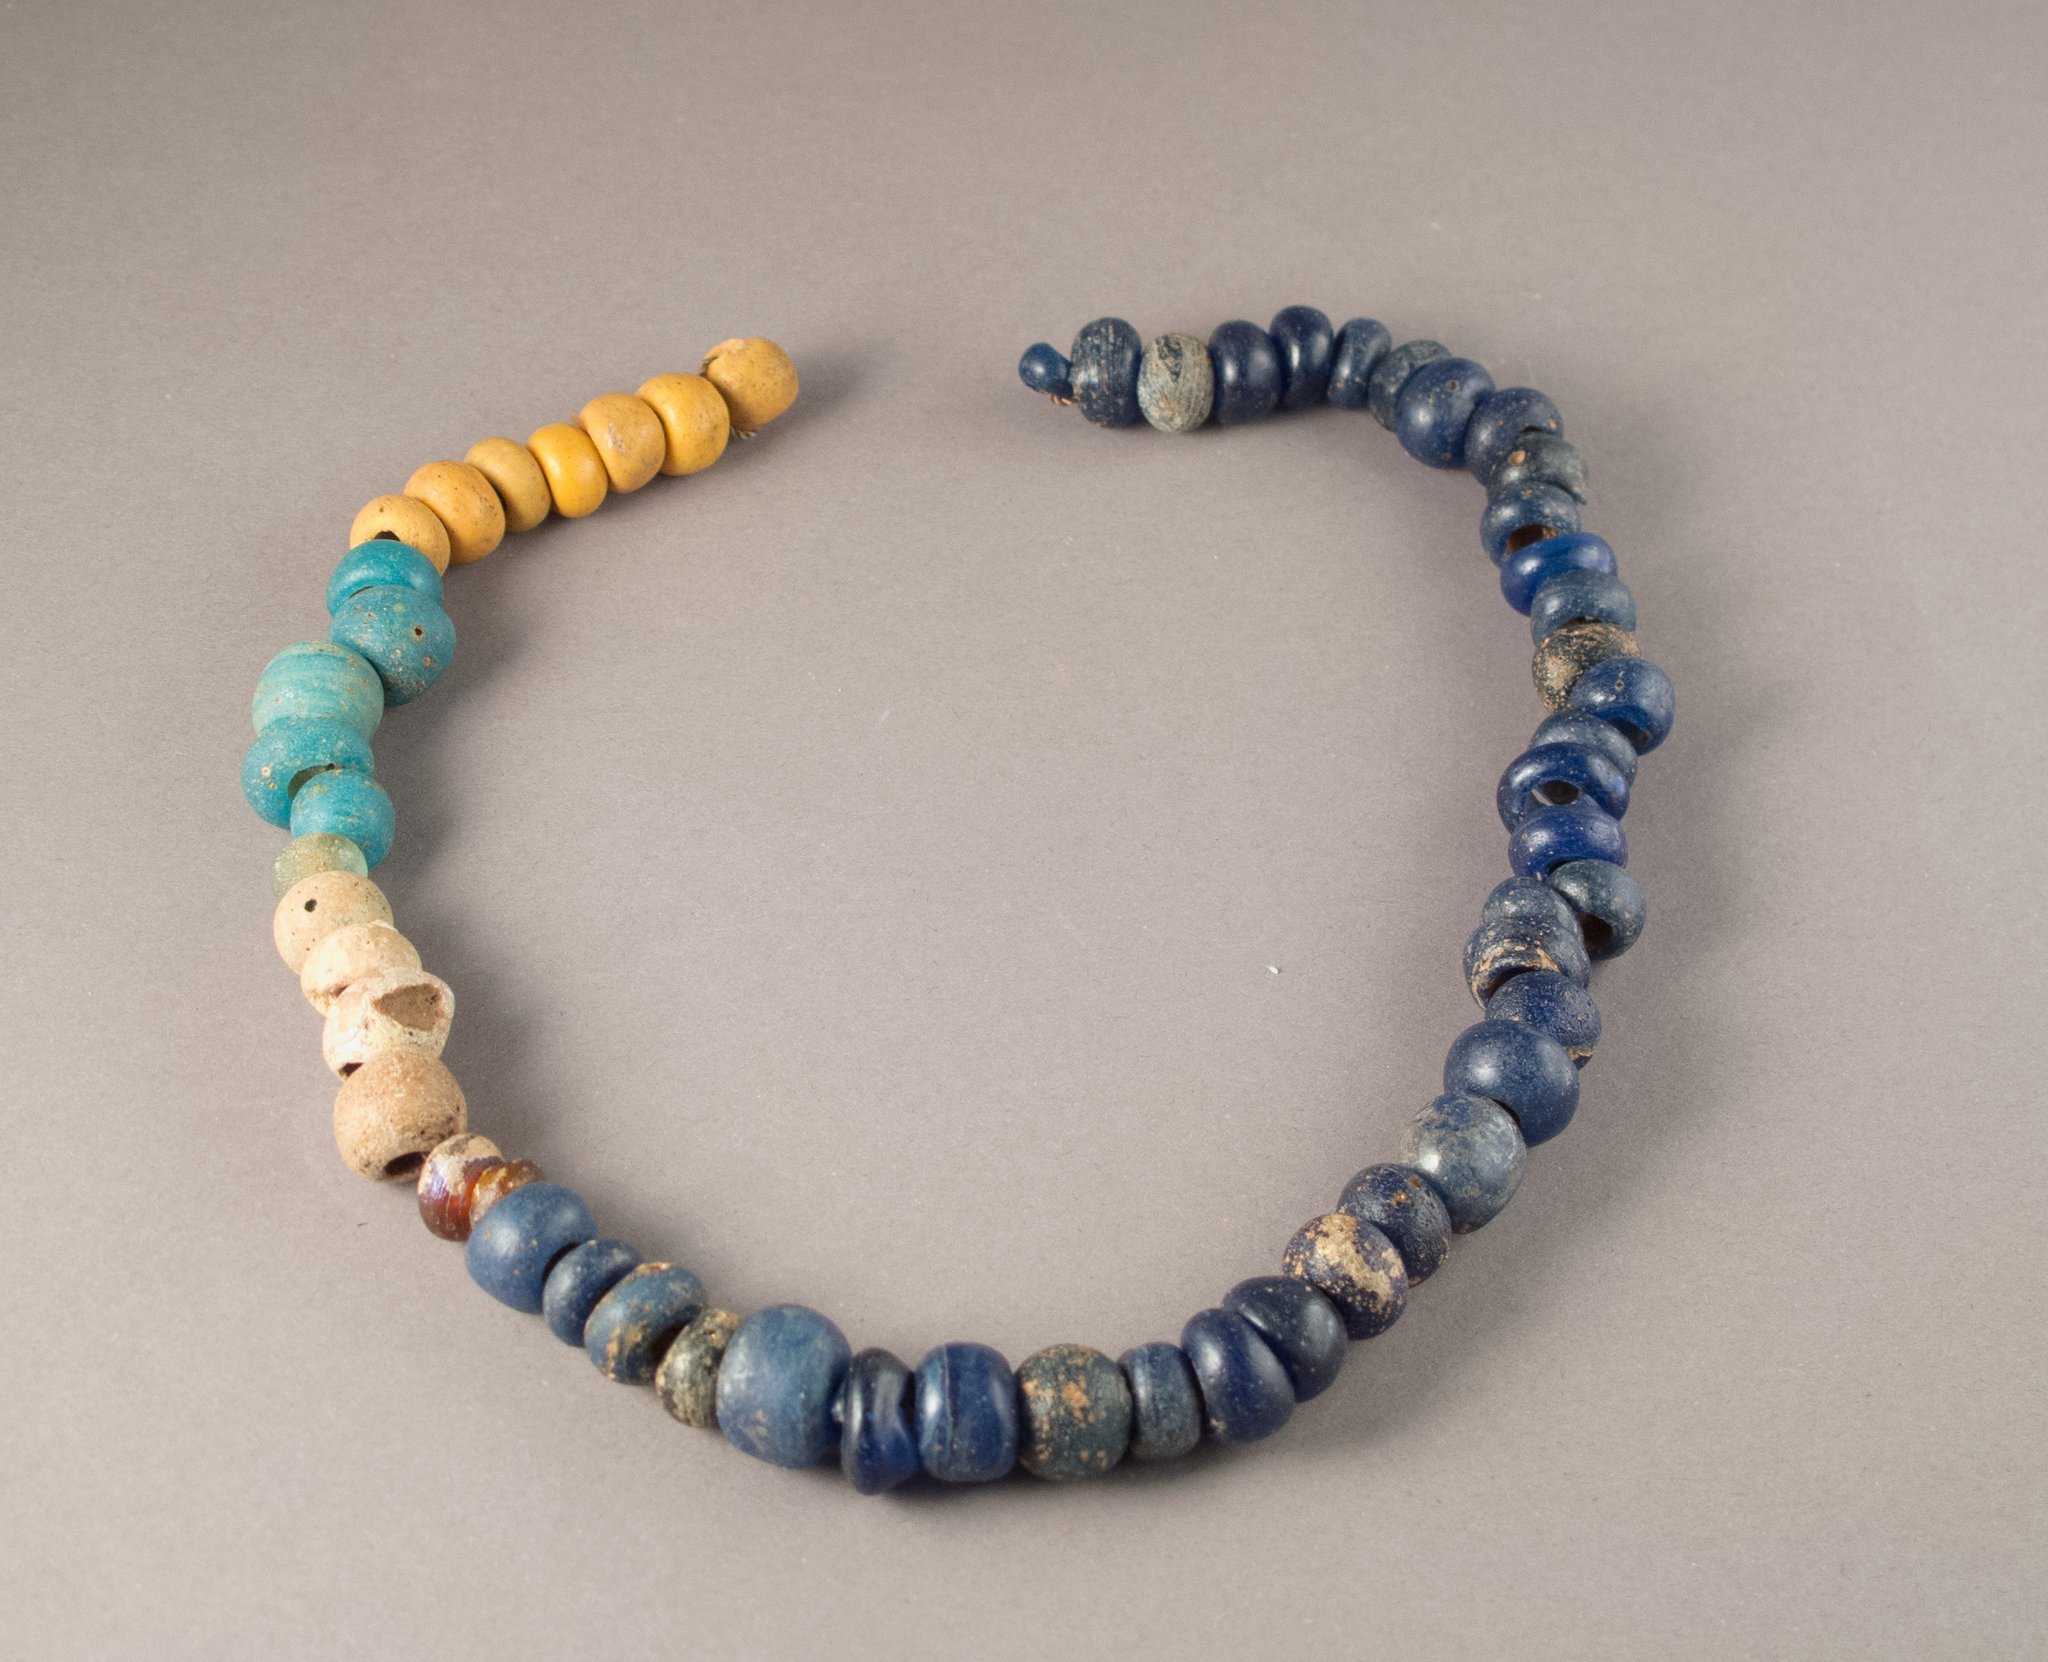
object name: bead, 56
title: Glass beads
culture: etruscan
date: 600-401 BCE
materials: glass